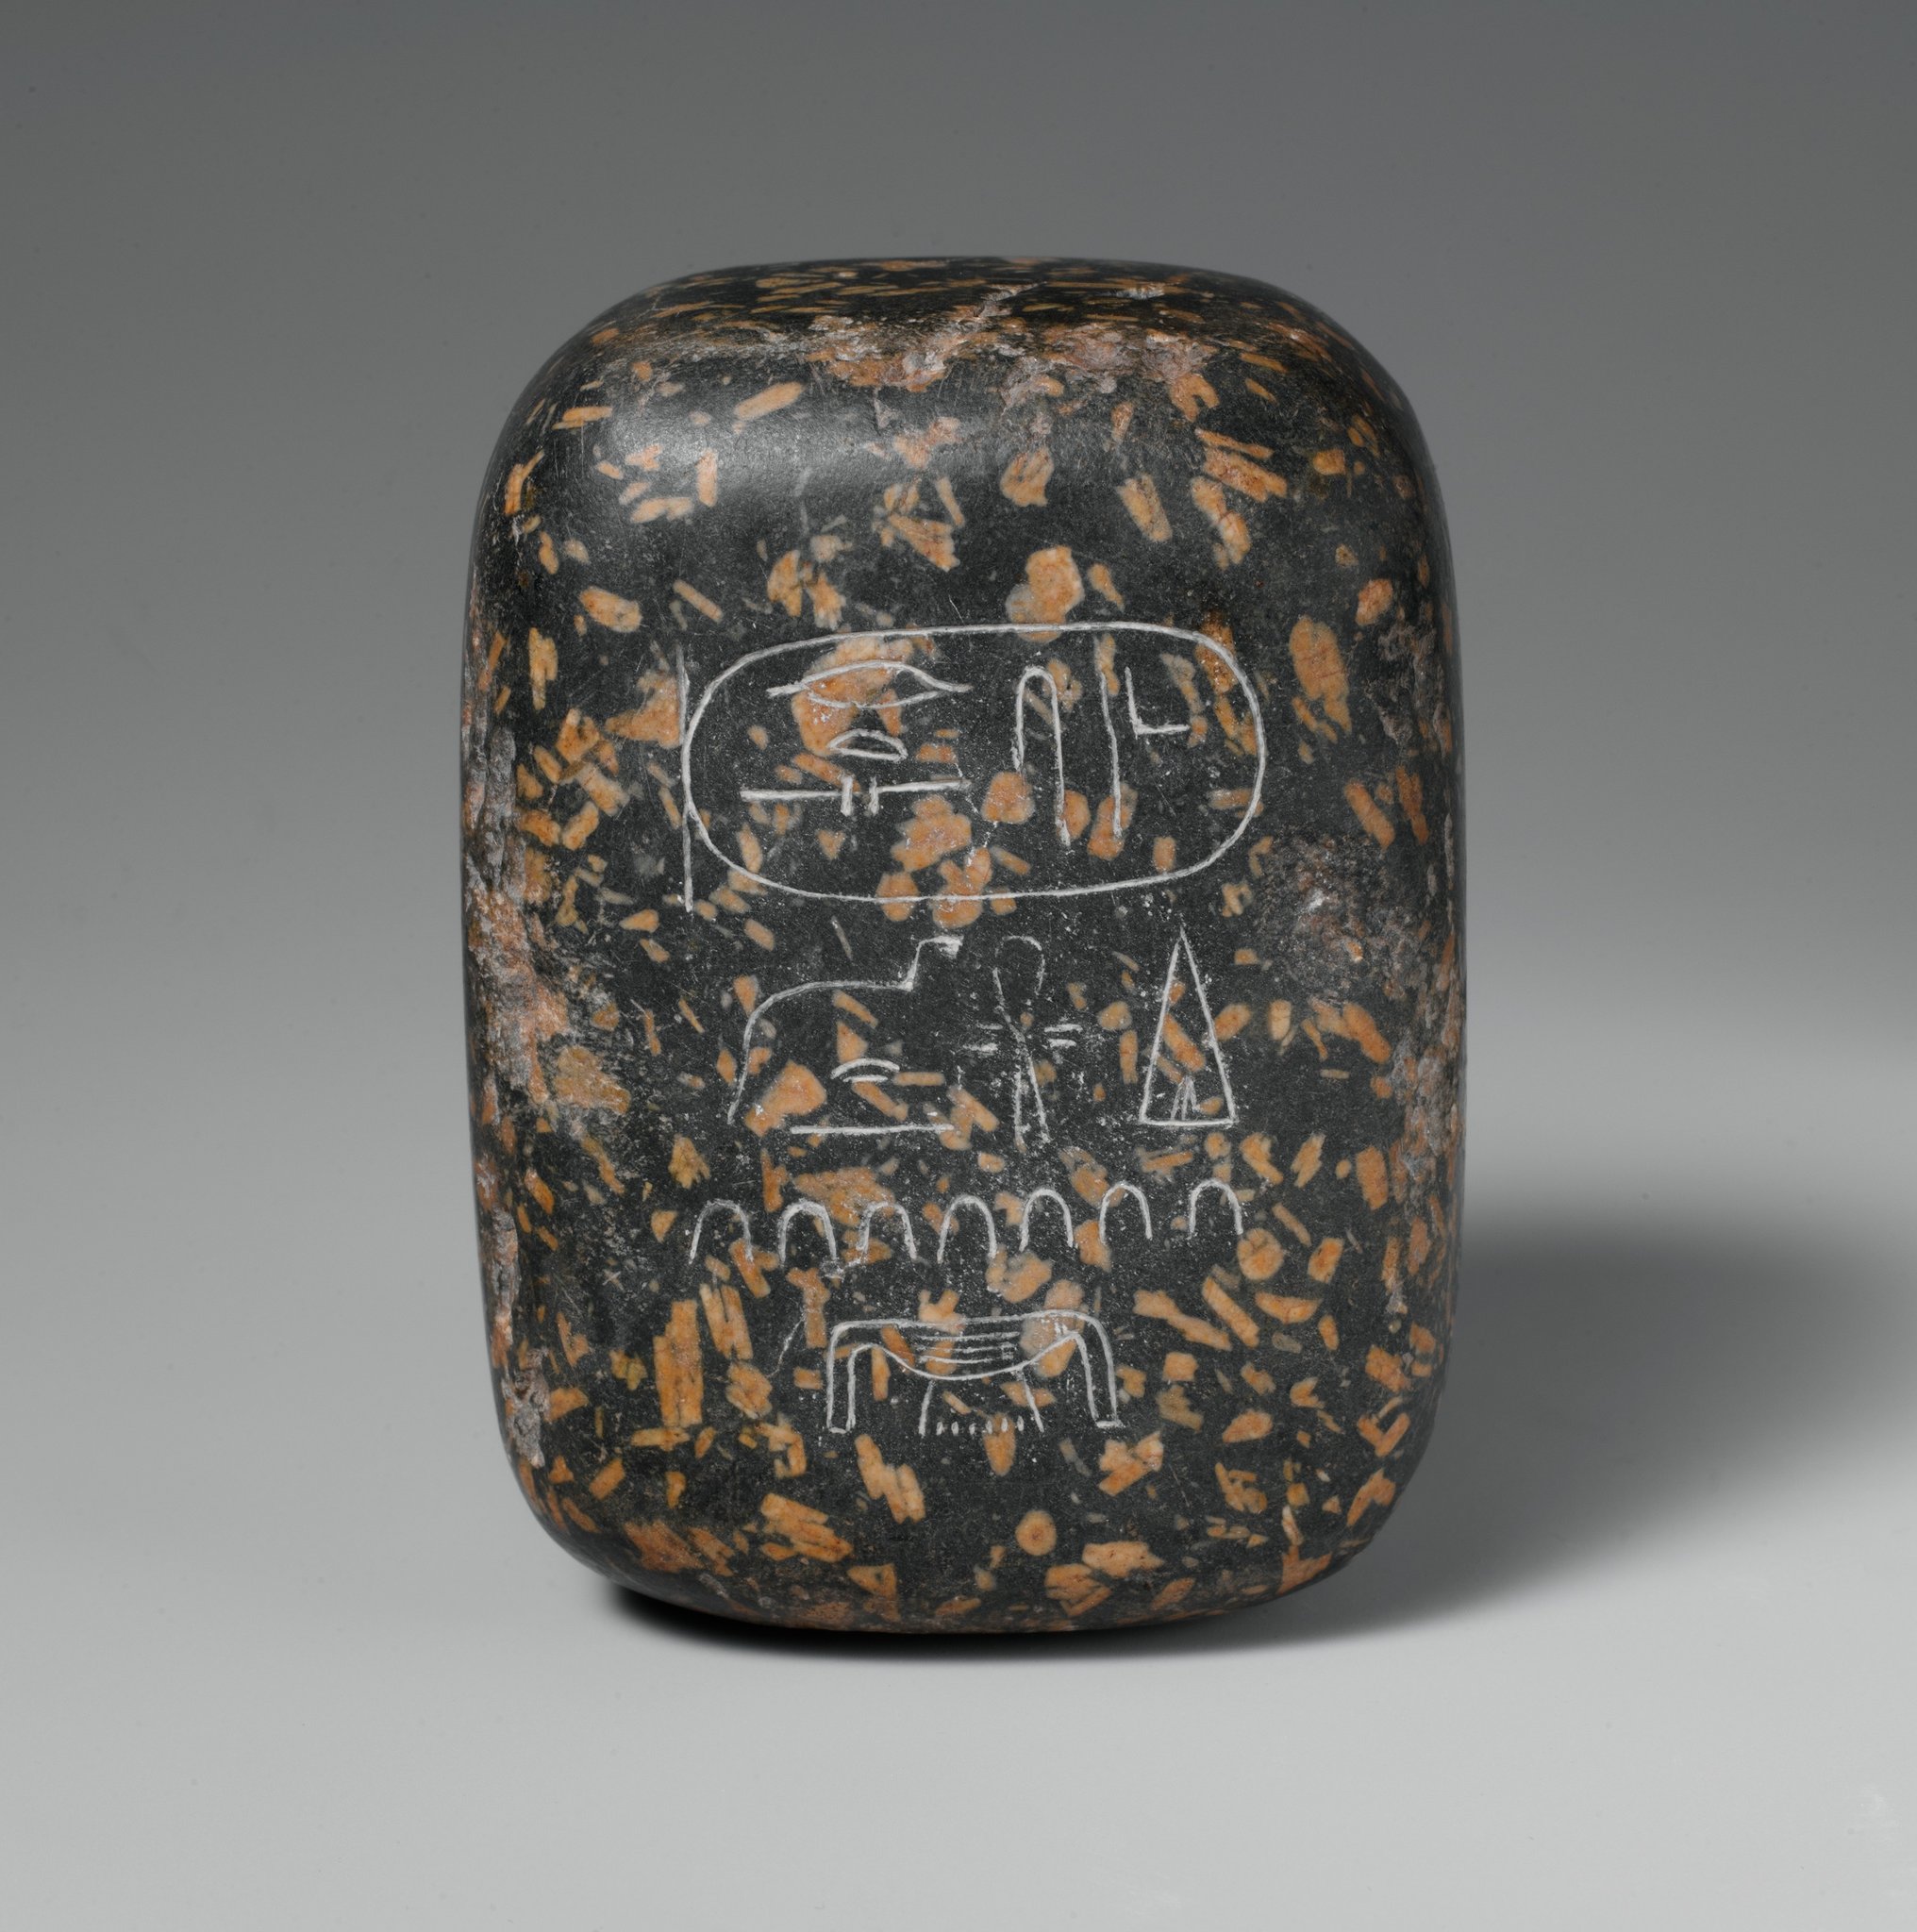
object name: weight, 70 deben, cube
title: Seventy deben weight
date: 1850-1640 BCE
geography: egypt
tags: hieroglyphs